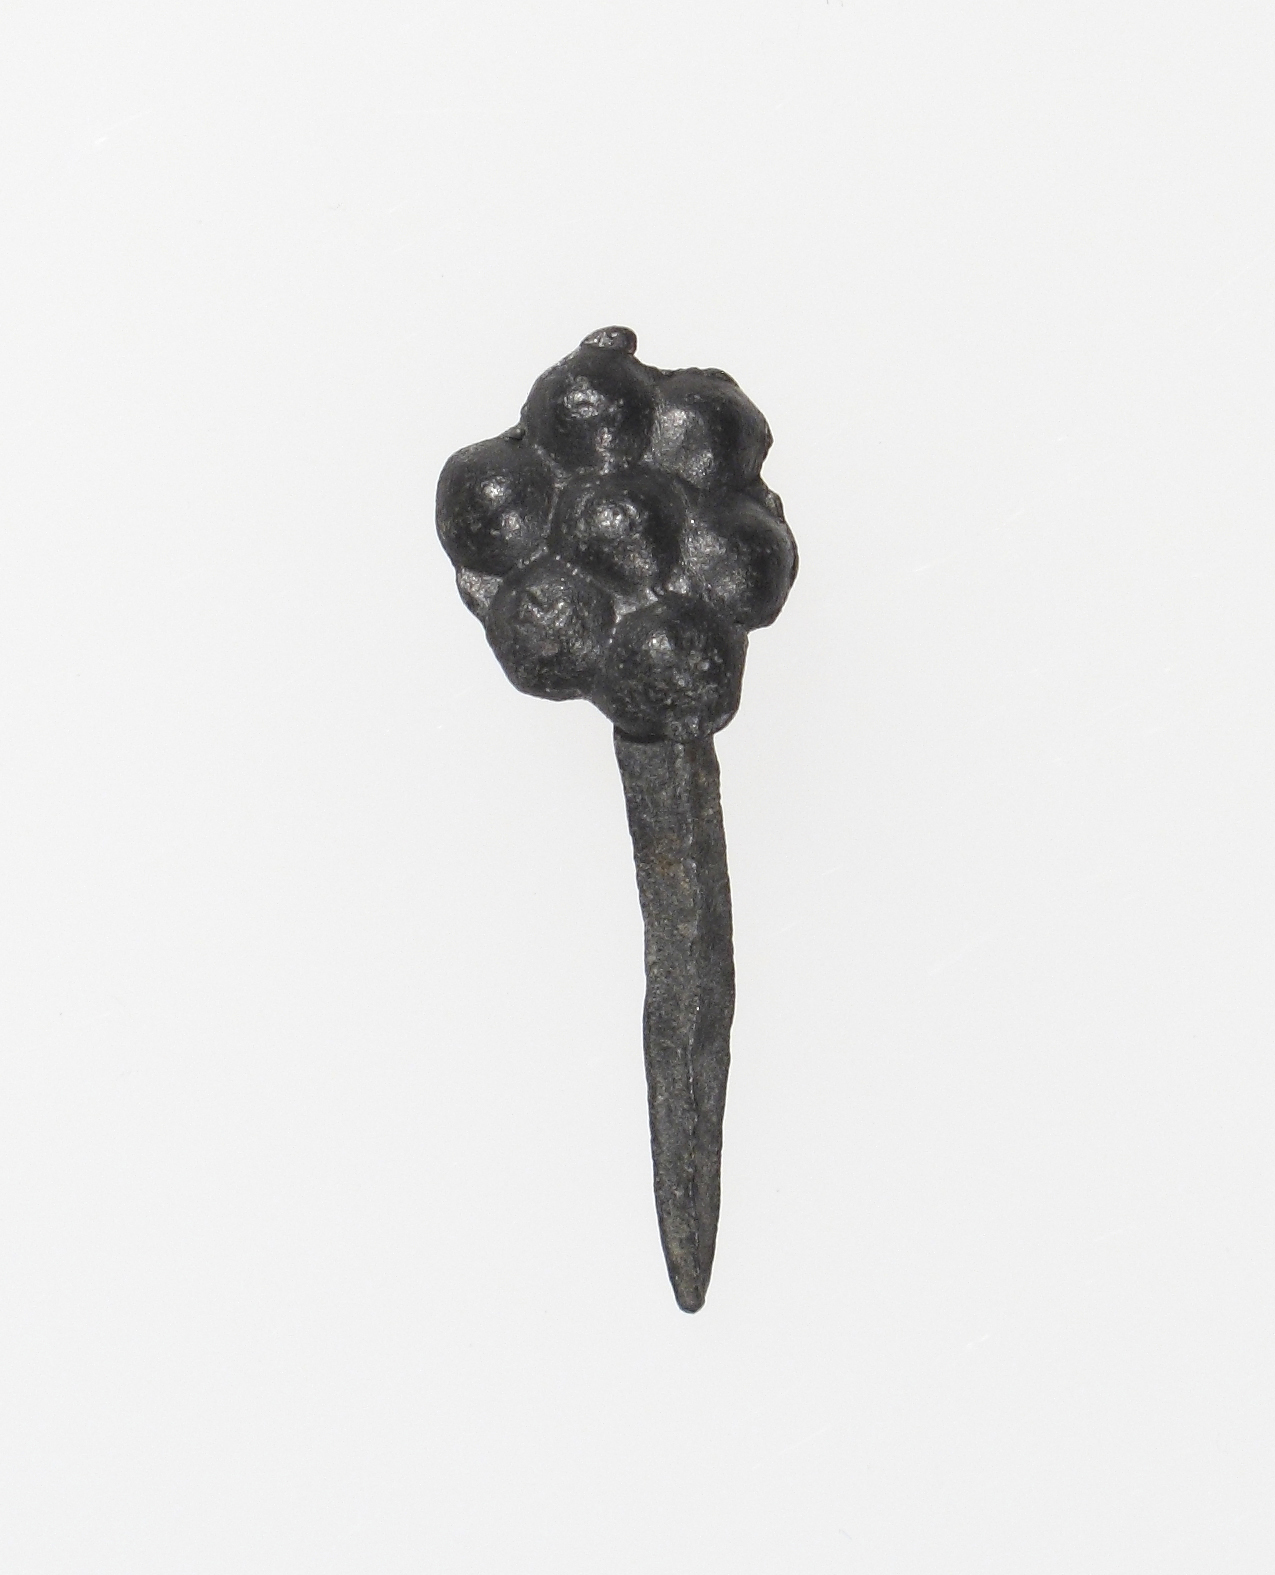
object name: pilgrim's badge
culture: french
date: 1301-1600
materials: lead